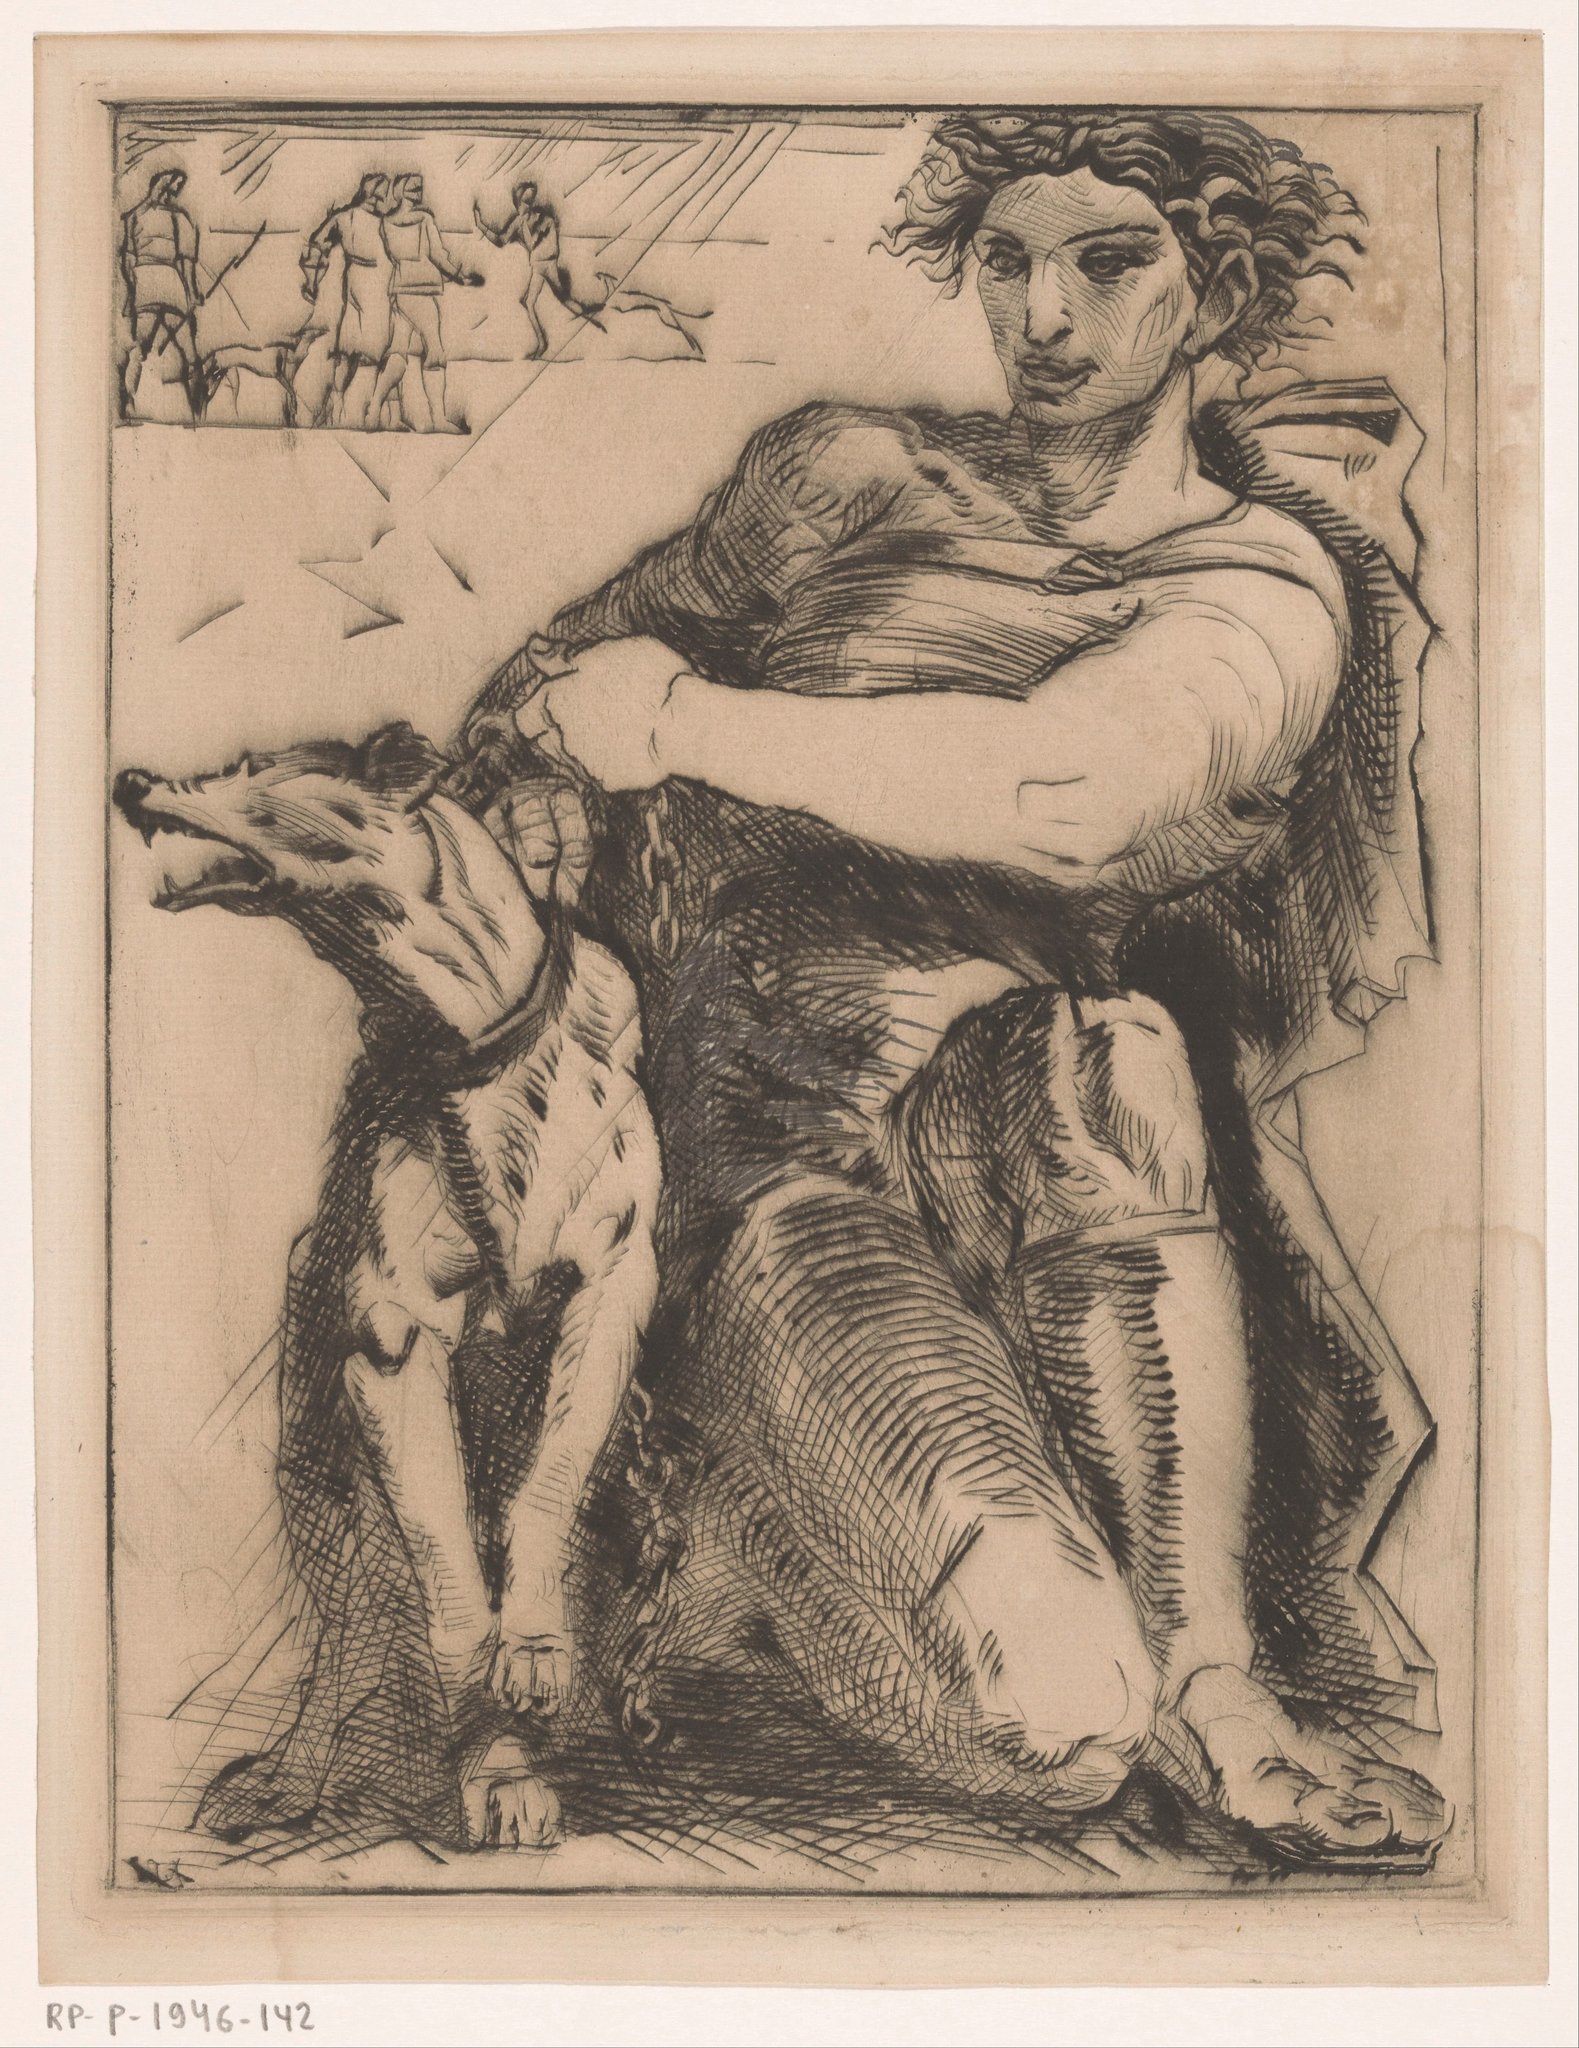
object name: print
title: Jachtknecht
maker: willem van konijnenburg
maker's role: draughtsman, painter, print maker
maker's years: 1868-1943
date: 1878-1943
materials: ink, paper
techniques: drypoint, intaglio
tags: hunter, dog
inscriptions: collector's mark: Lugt 2760, collector's mark: Lugt 2228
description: Een geknielde figuur die een hond aan een halsband vasthoudt. Links op de achtergrond nog enkele figuren met honden.